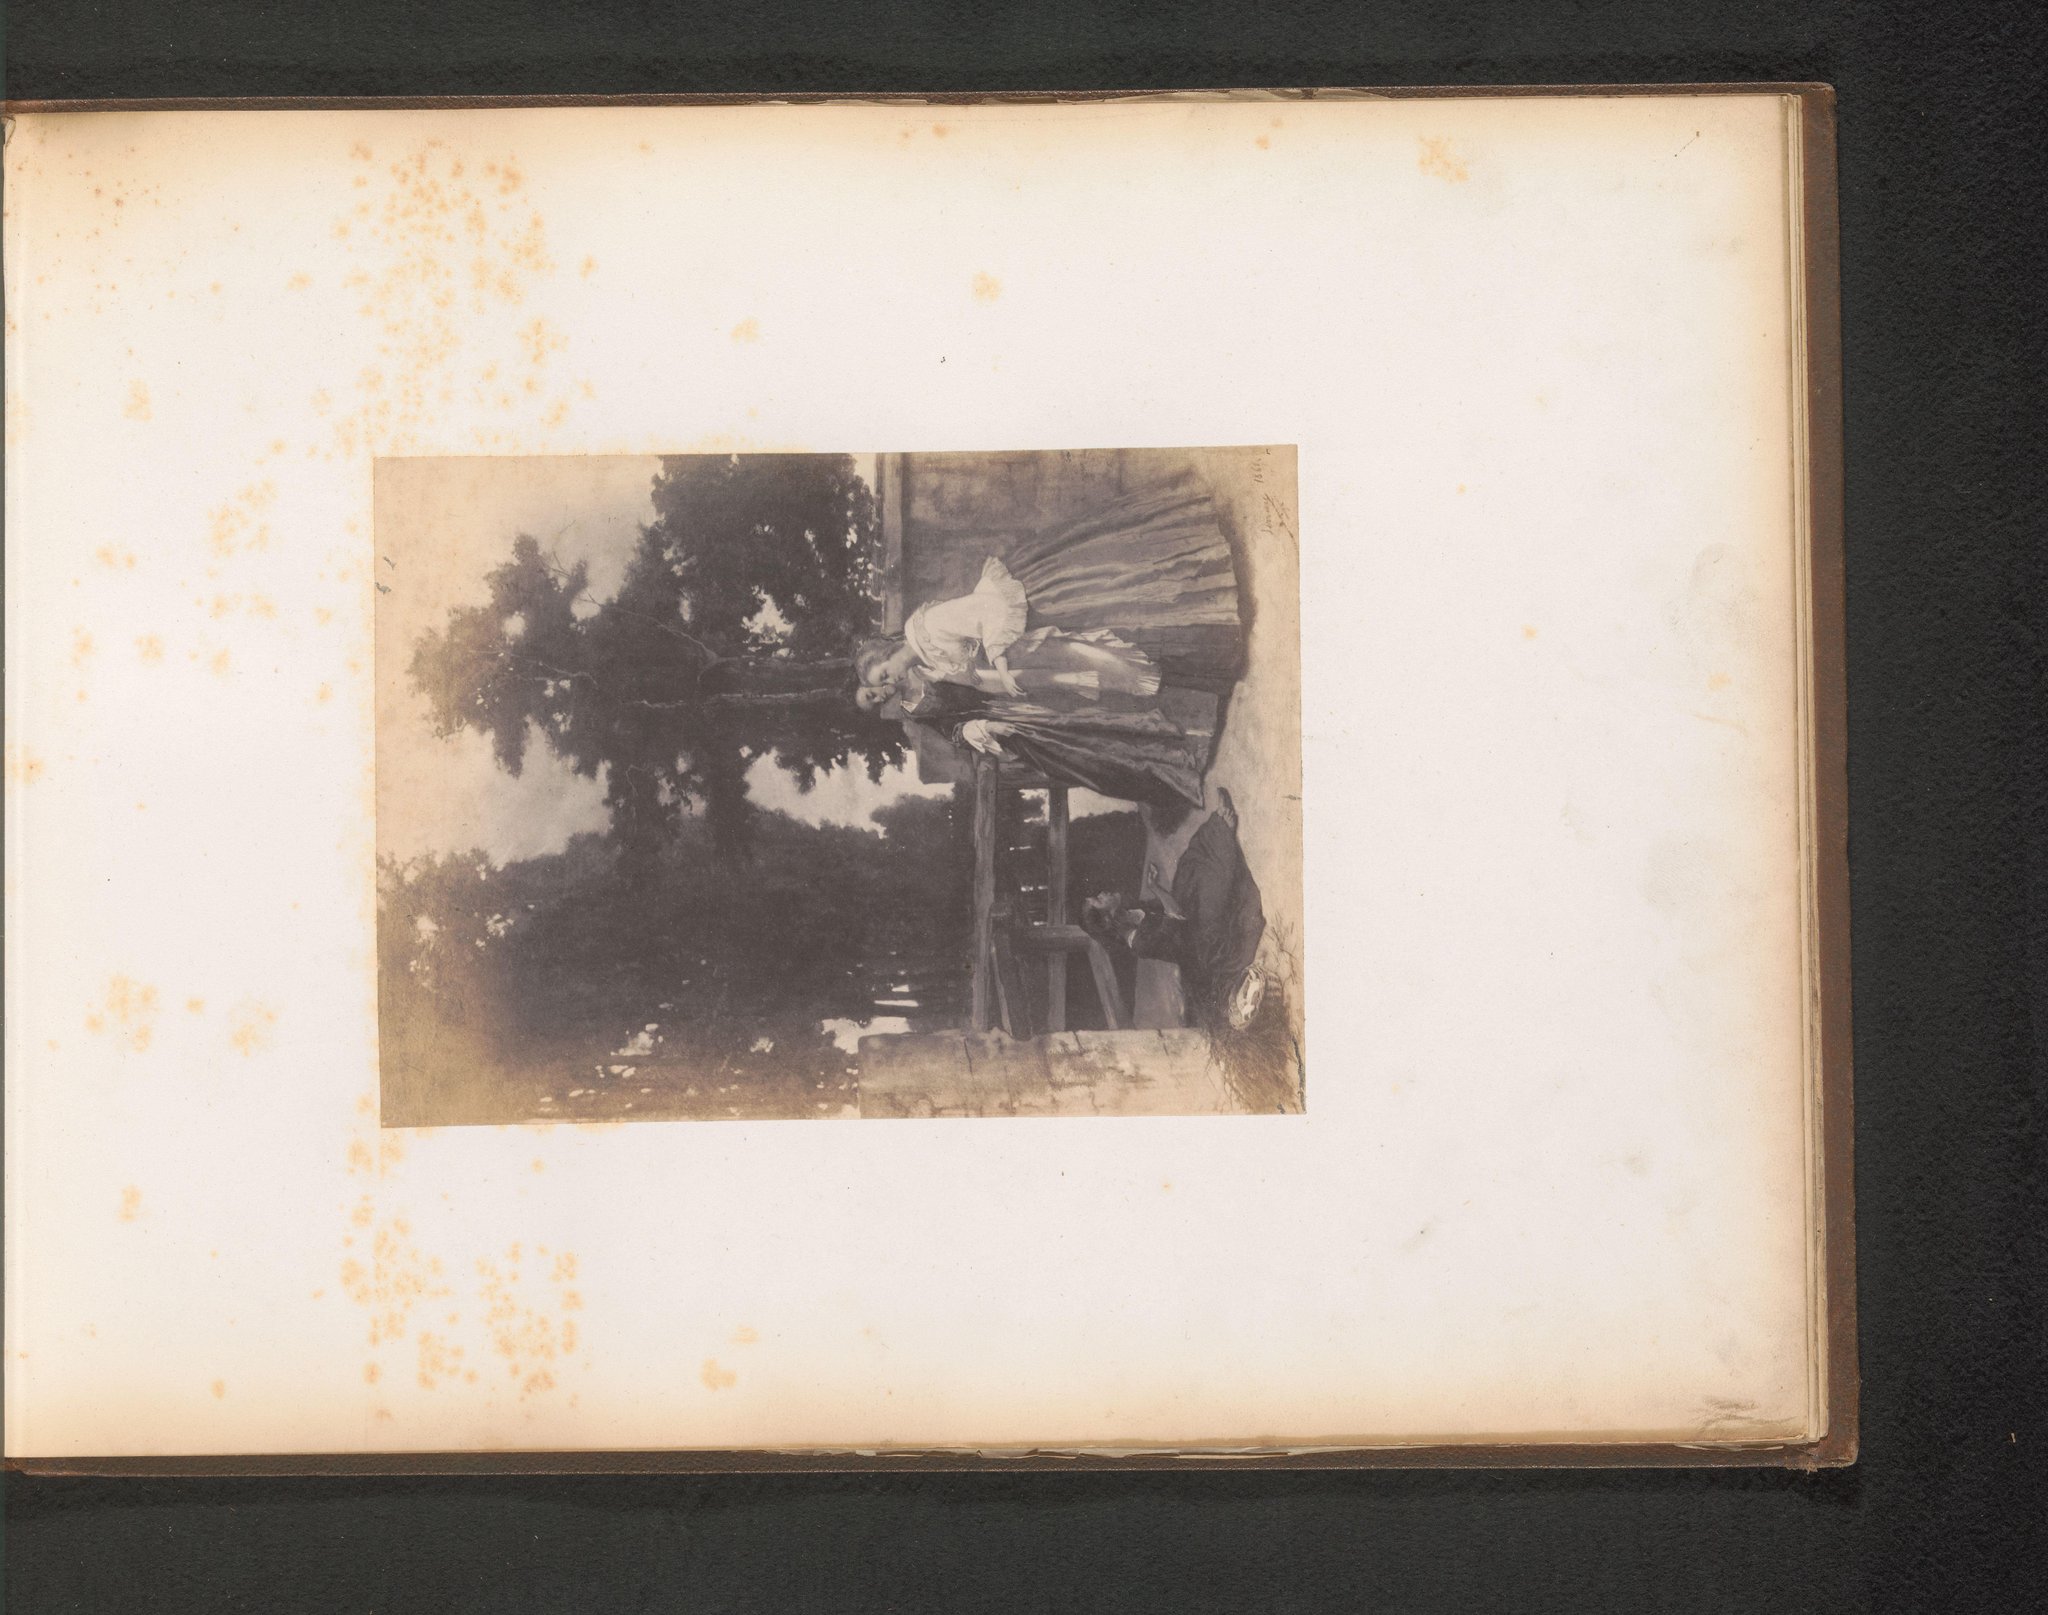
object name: photograph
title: Fotoreproductie van L'Aumone van Auguste Serrure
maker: Anonymous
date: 1858-1863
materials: photographic support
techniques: albumen print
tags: adolescent, young woman, maiden, picture, painting, beggar